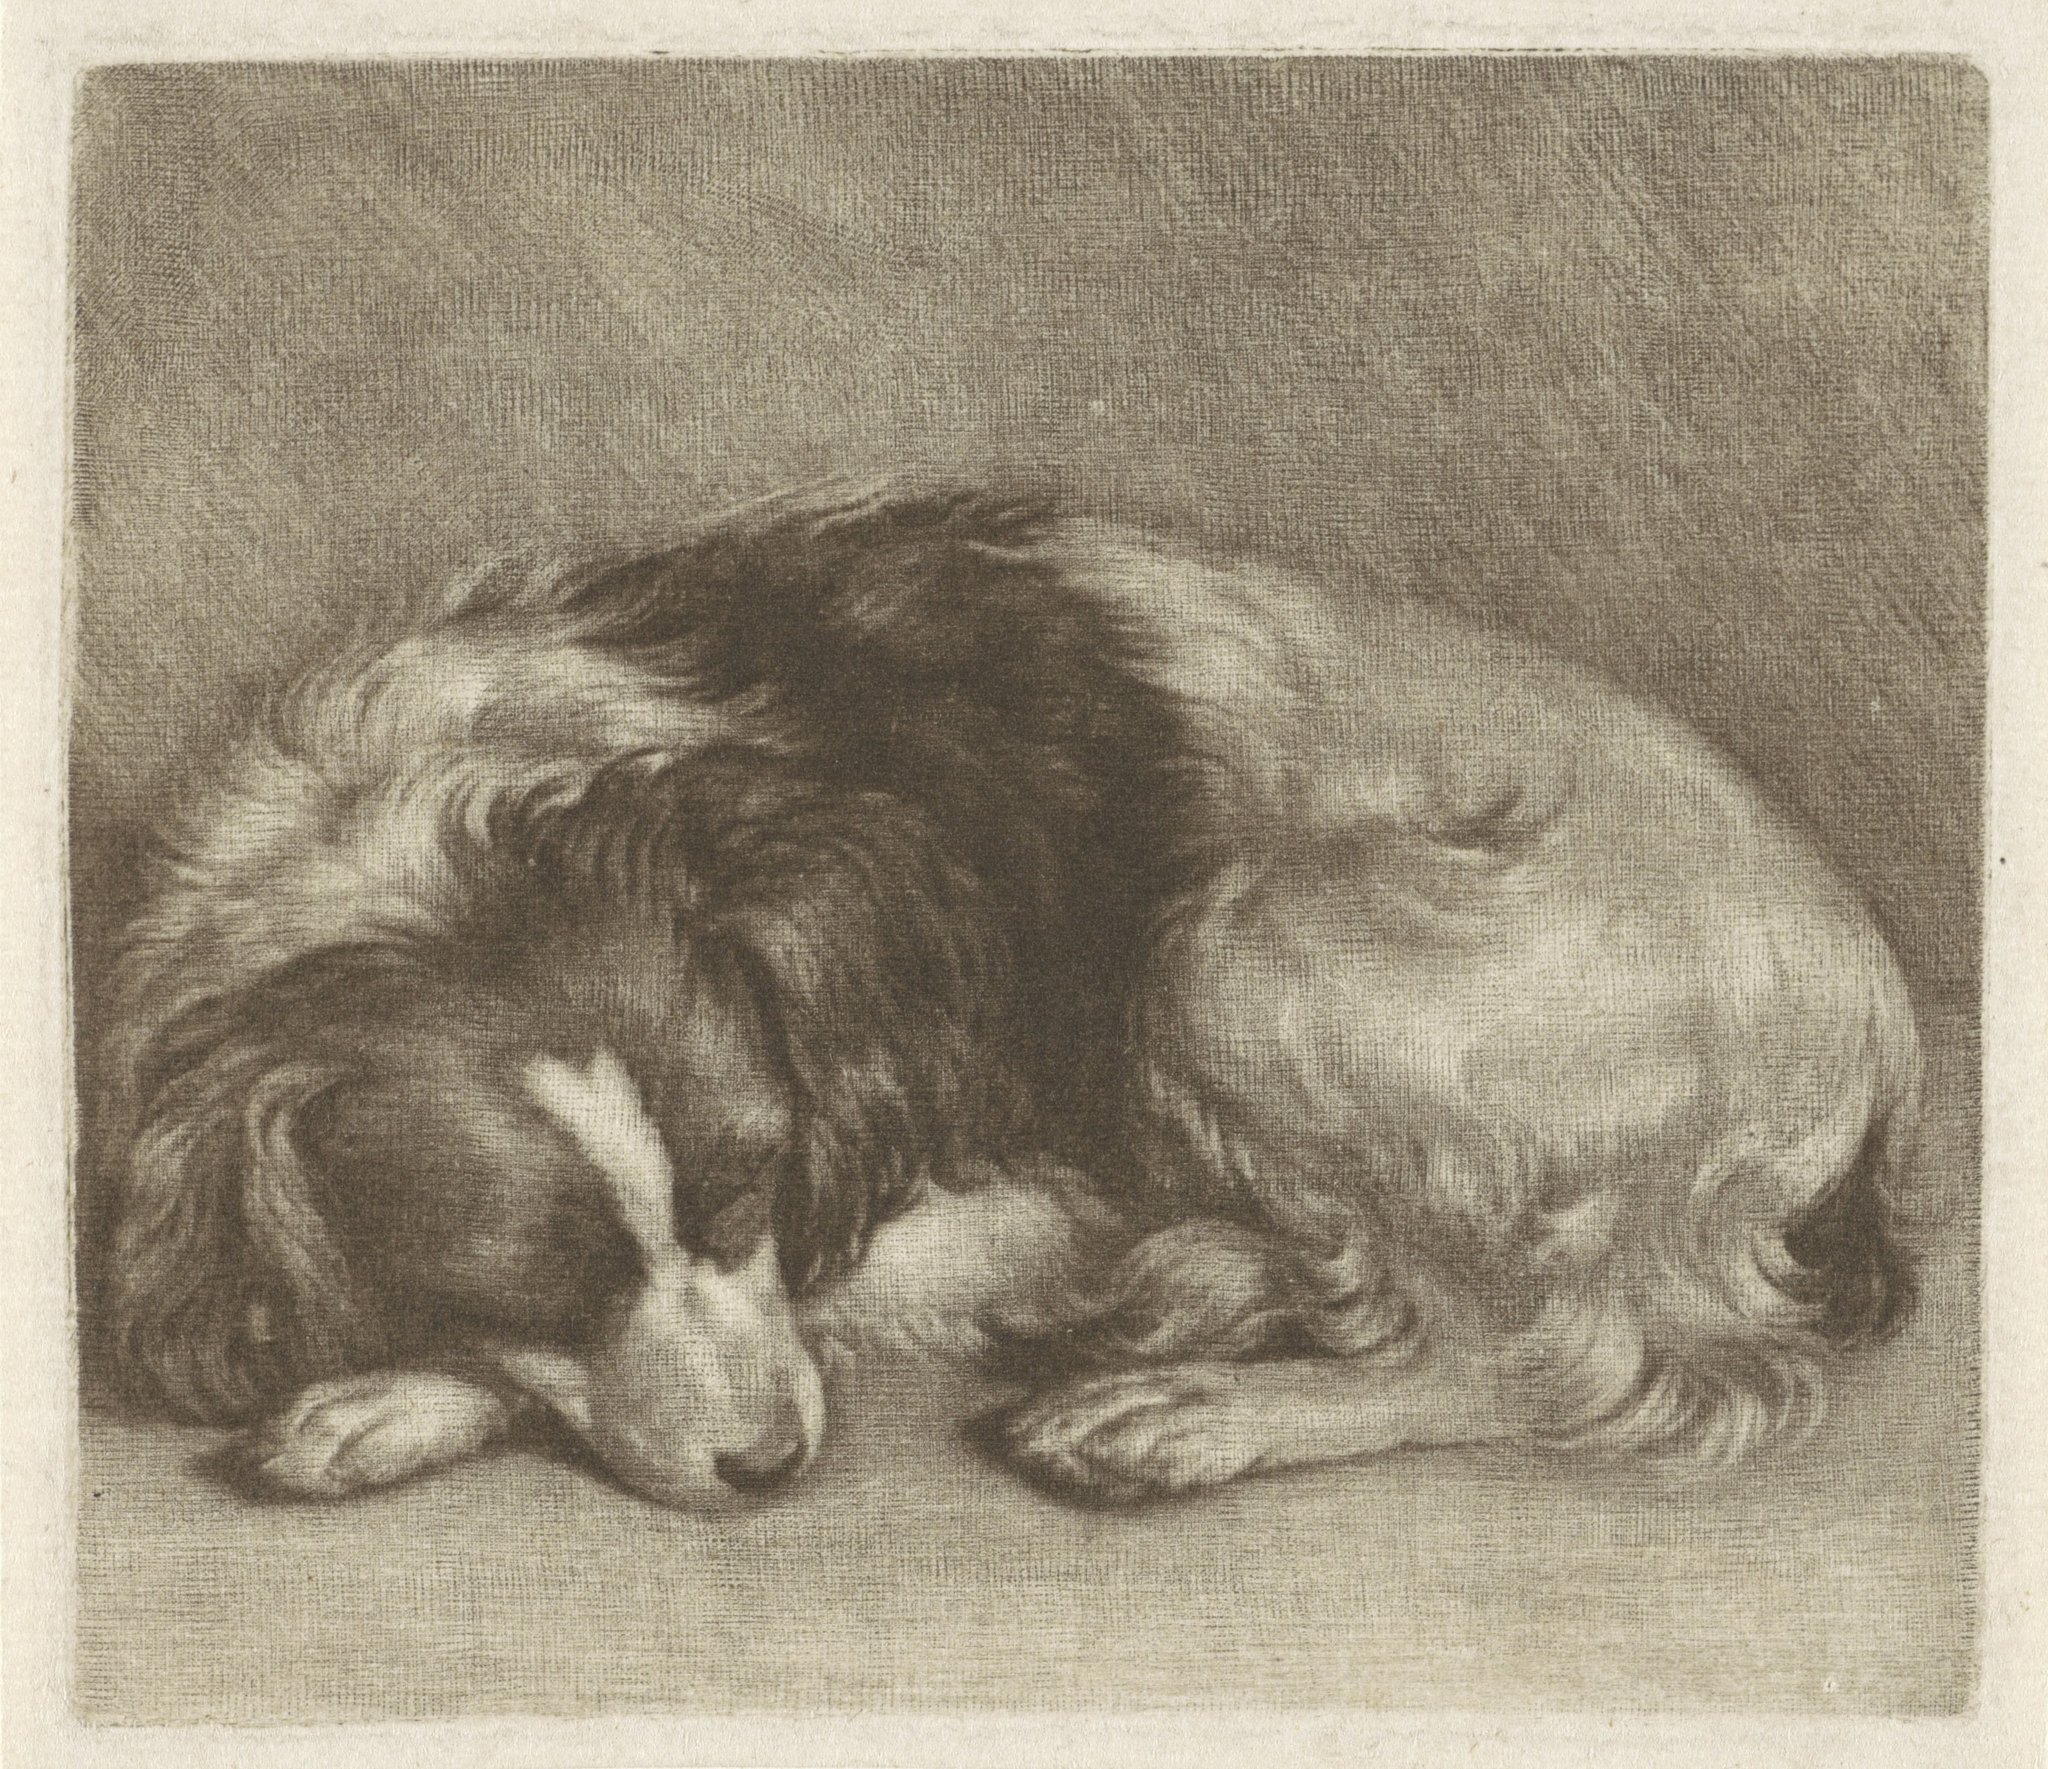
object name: print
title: Slapende hond, mogelijk een spaniël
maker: jan verkolje (i)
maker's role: draughtsman, painter, print maker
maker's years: 1650-1693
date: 1660-1693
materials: paper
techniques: printing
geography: delft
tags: sleeping; unconsciousness, dog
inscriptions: collector's mark: Lugt 240